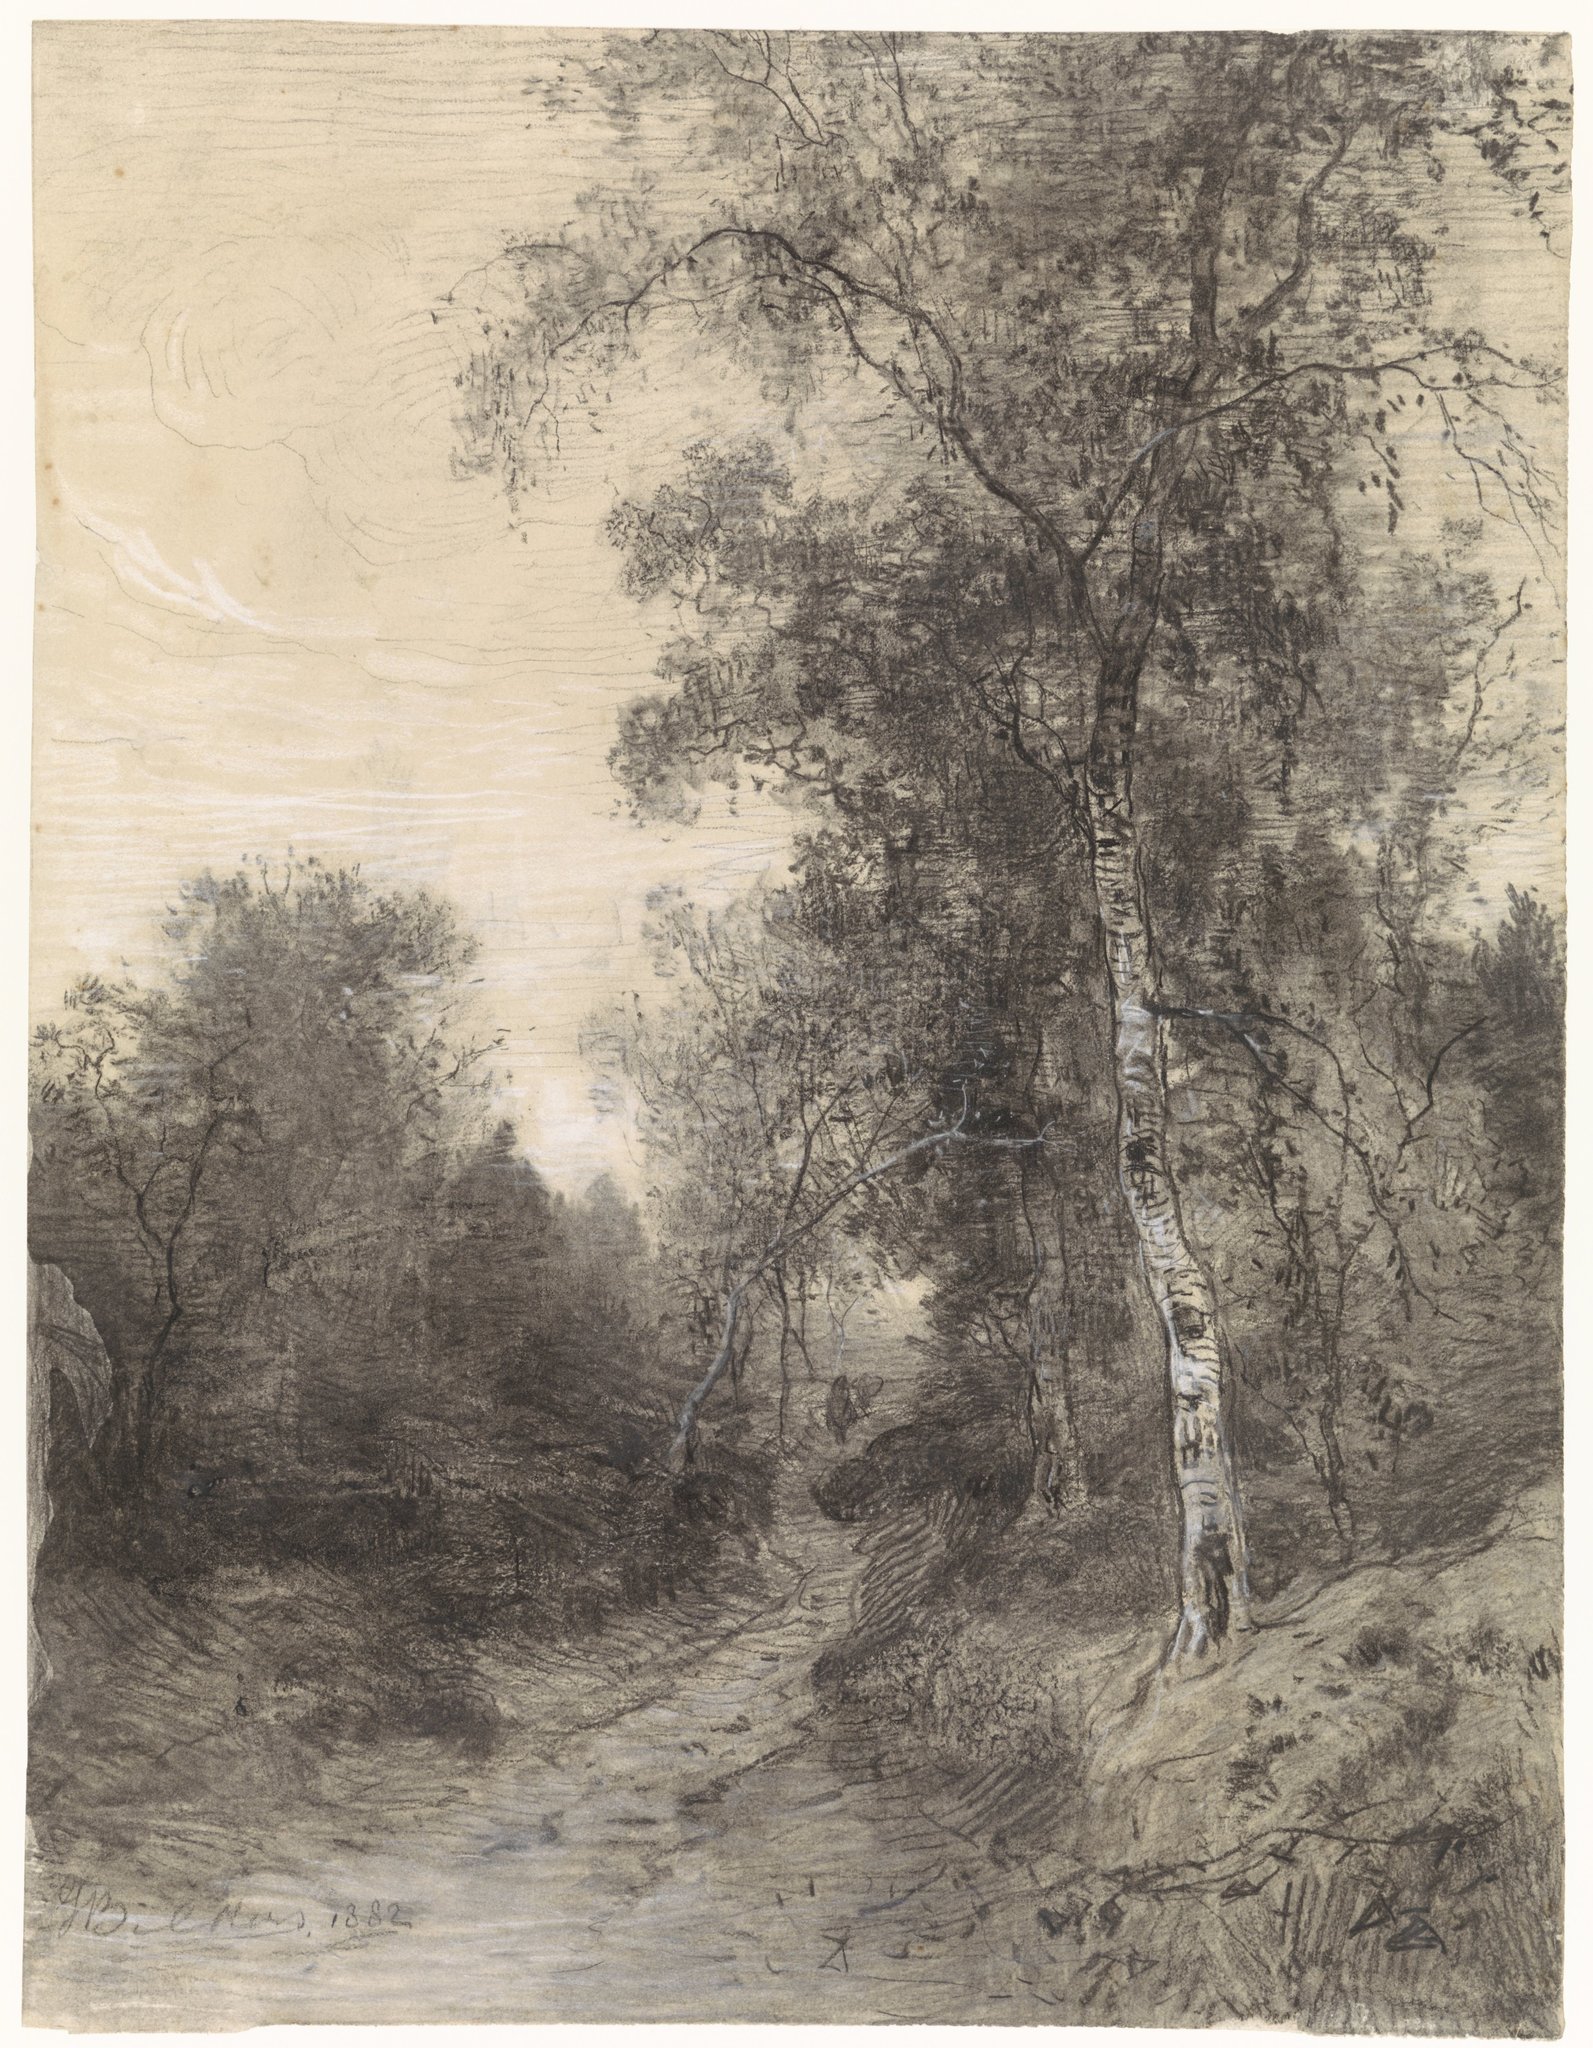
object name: drawing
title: Bosgezicht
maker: johannes warnardus bilders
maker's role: painter, print maker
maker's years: 1811-1890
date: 1882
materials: chalk, paper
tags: forest, wood